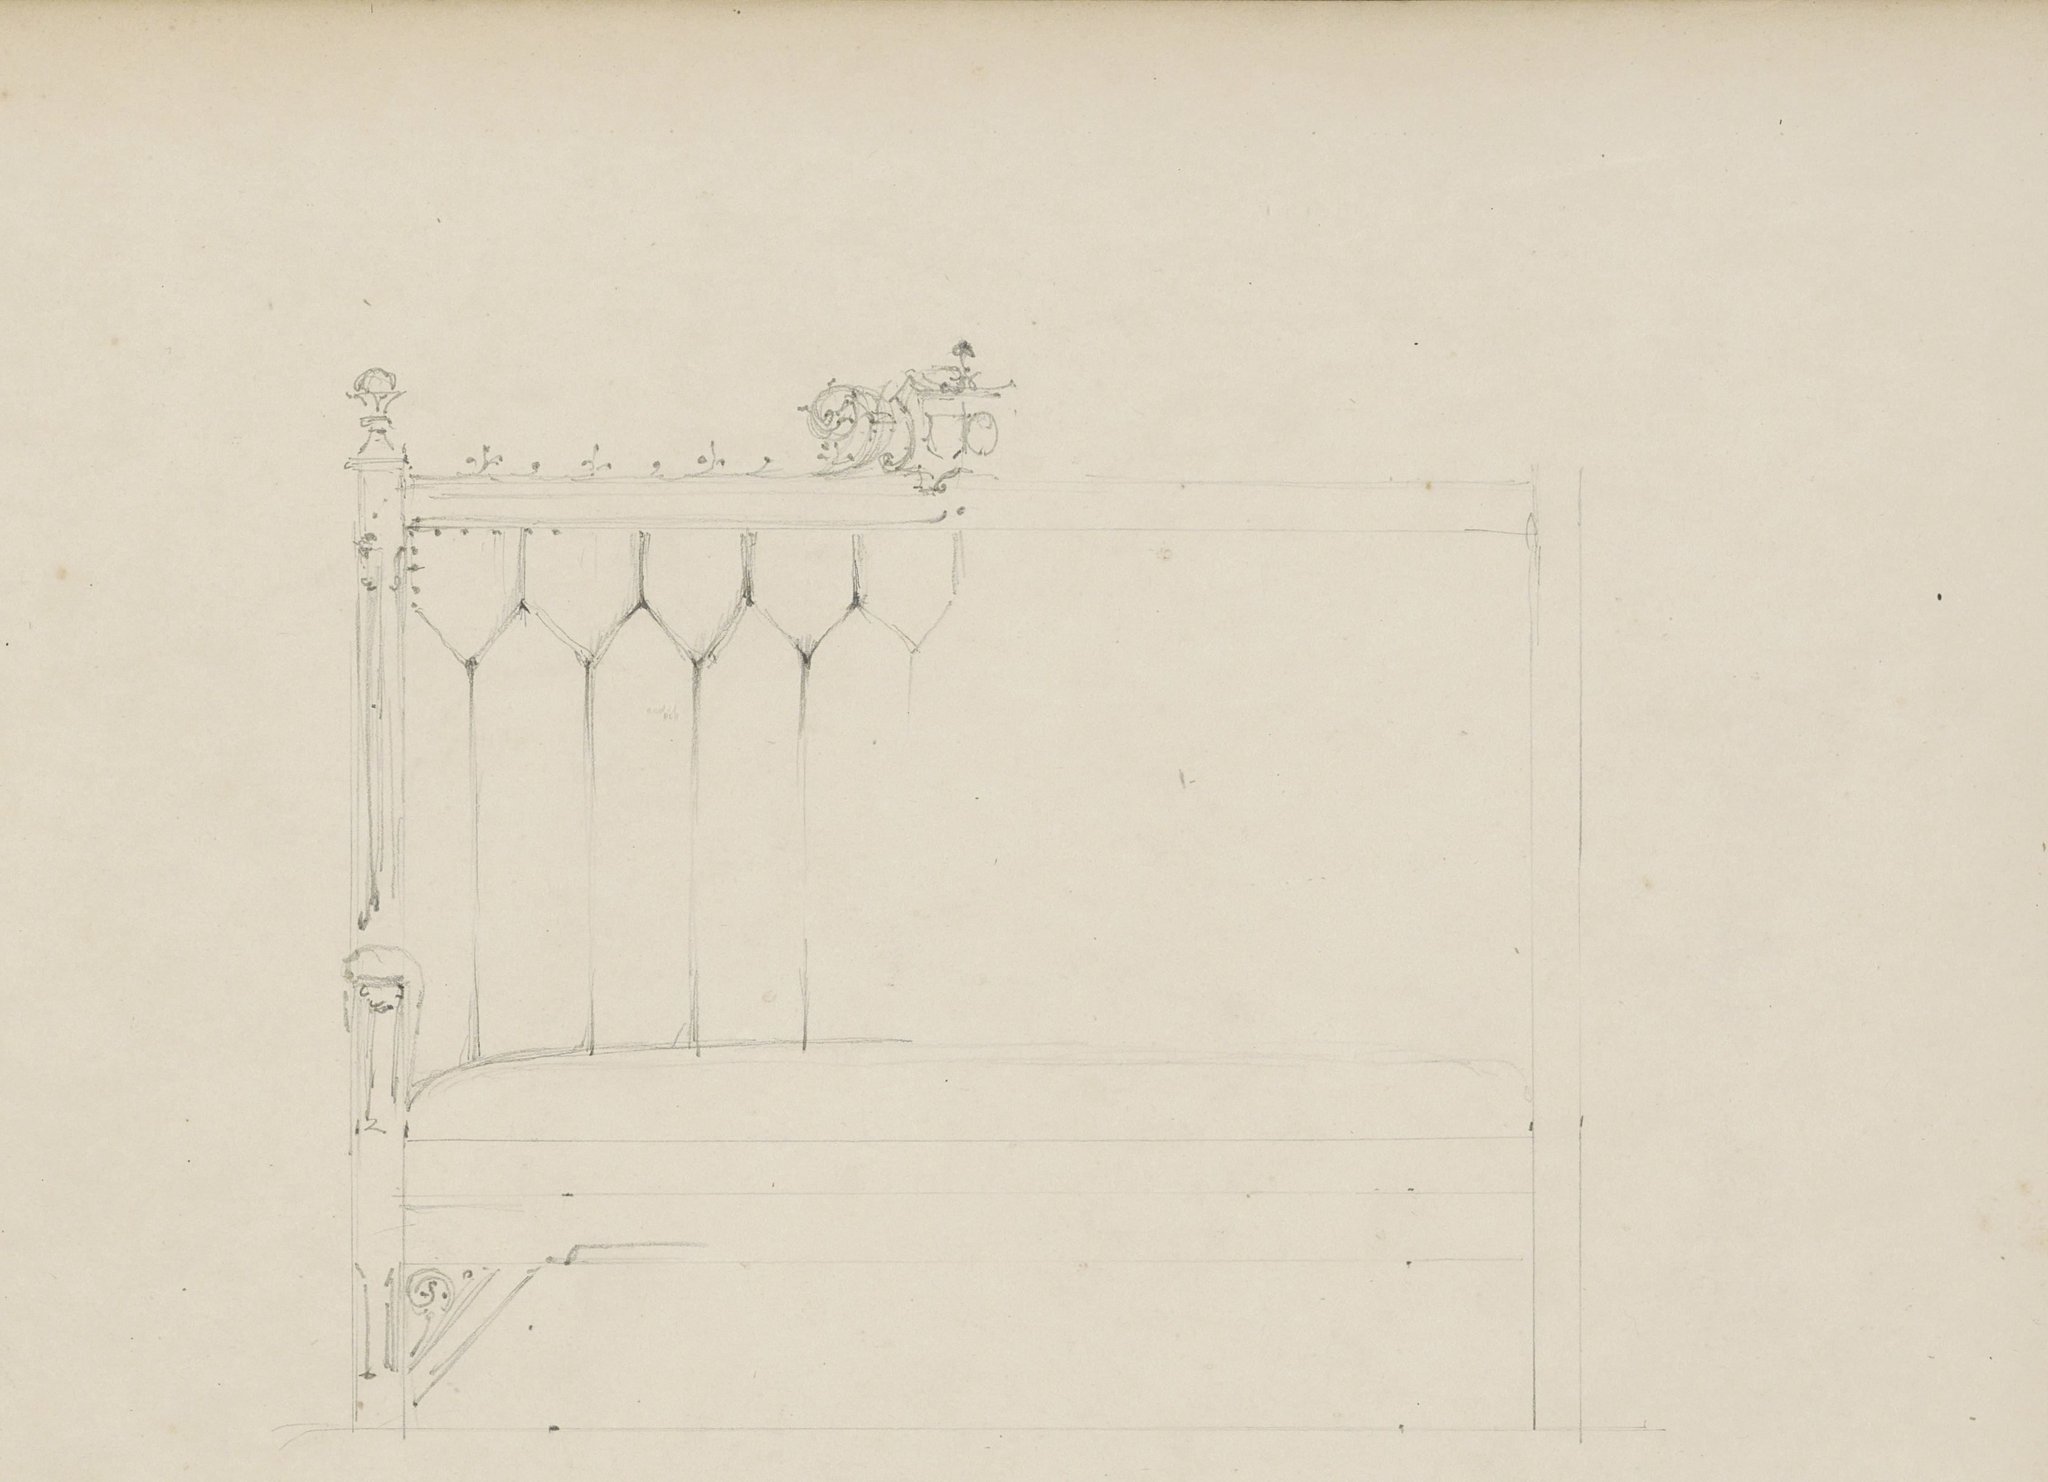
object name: sketchbook leaf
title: Sofa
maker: pierre joseph hubert cuypers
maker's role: draughtsman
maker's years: 1827-1921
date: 1857-1859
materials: paper, pencil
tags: couch, sofa, settee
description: Blad 49 recto uit een schetsboek met 77 bladen.